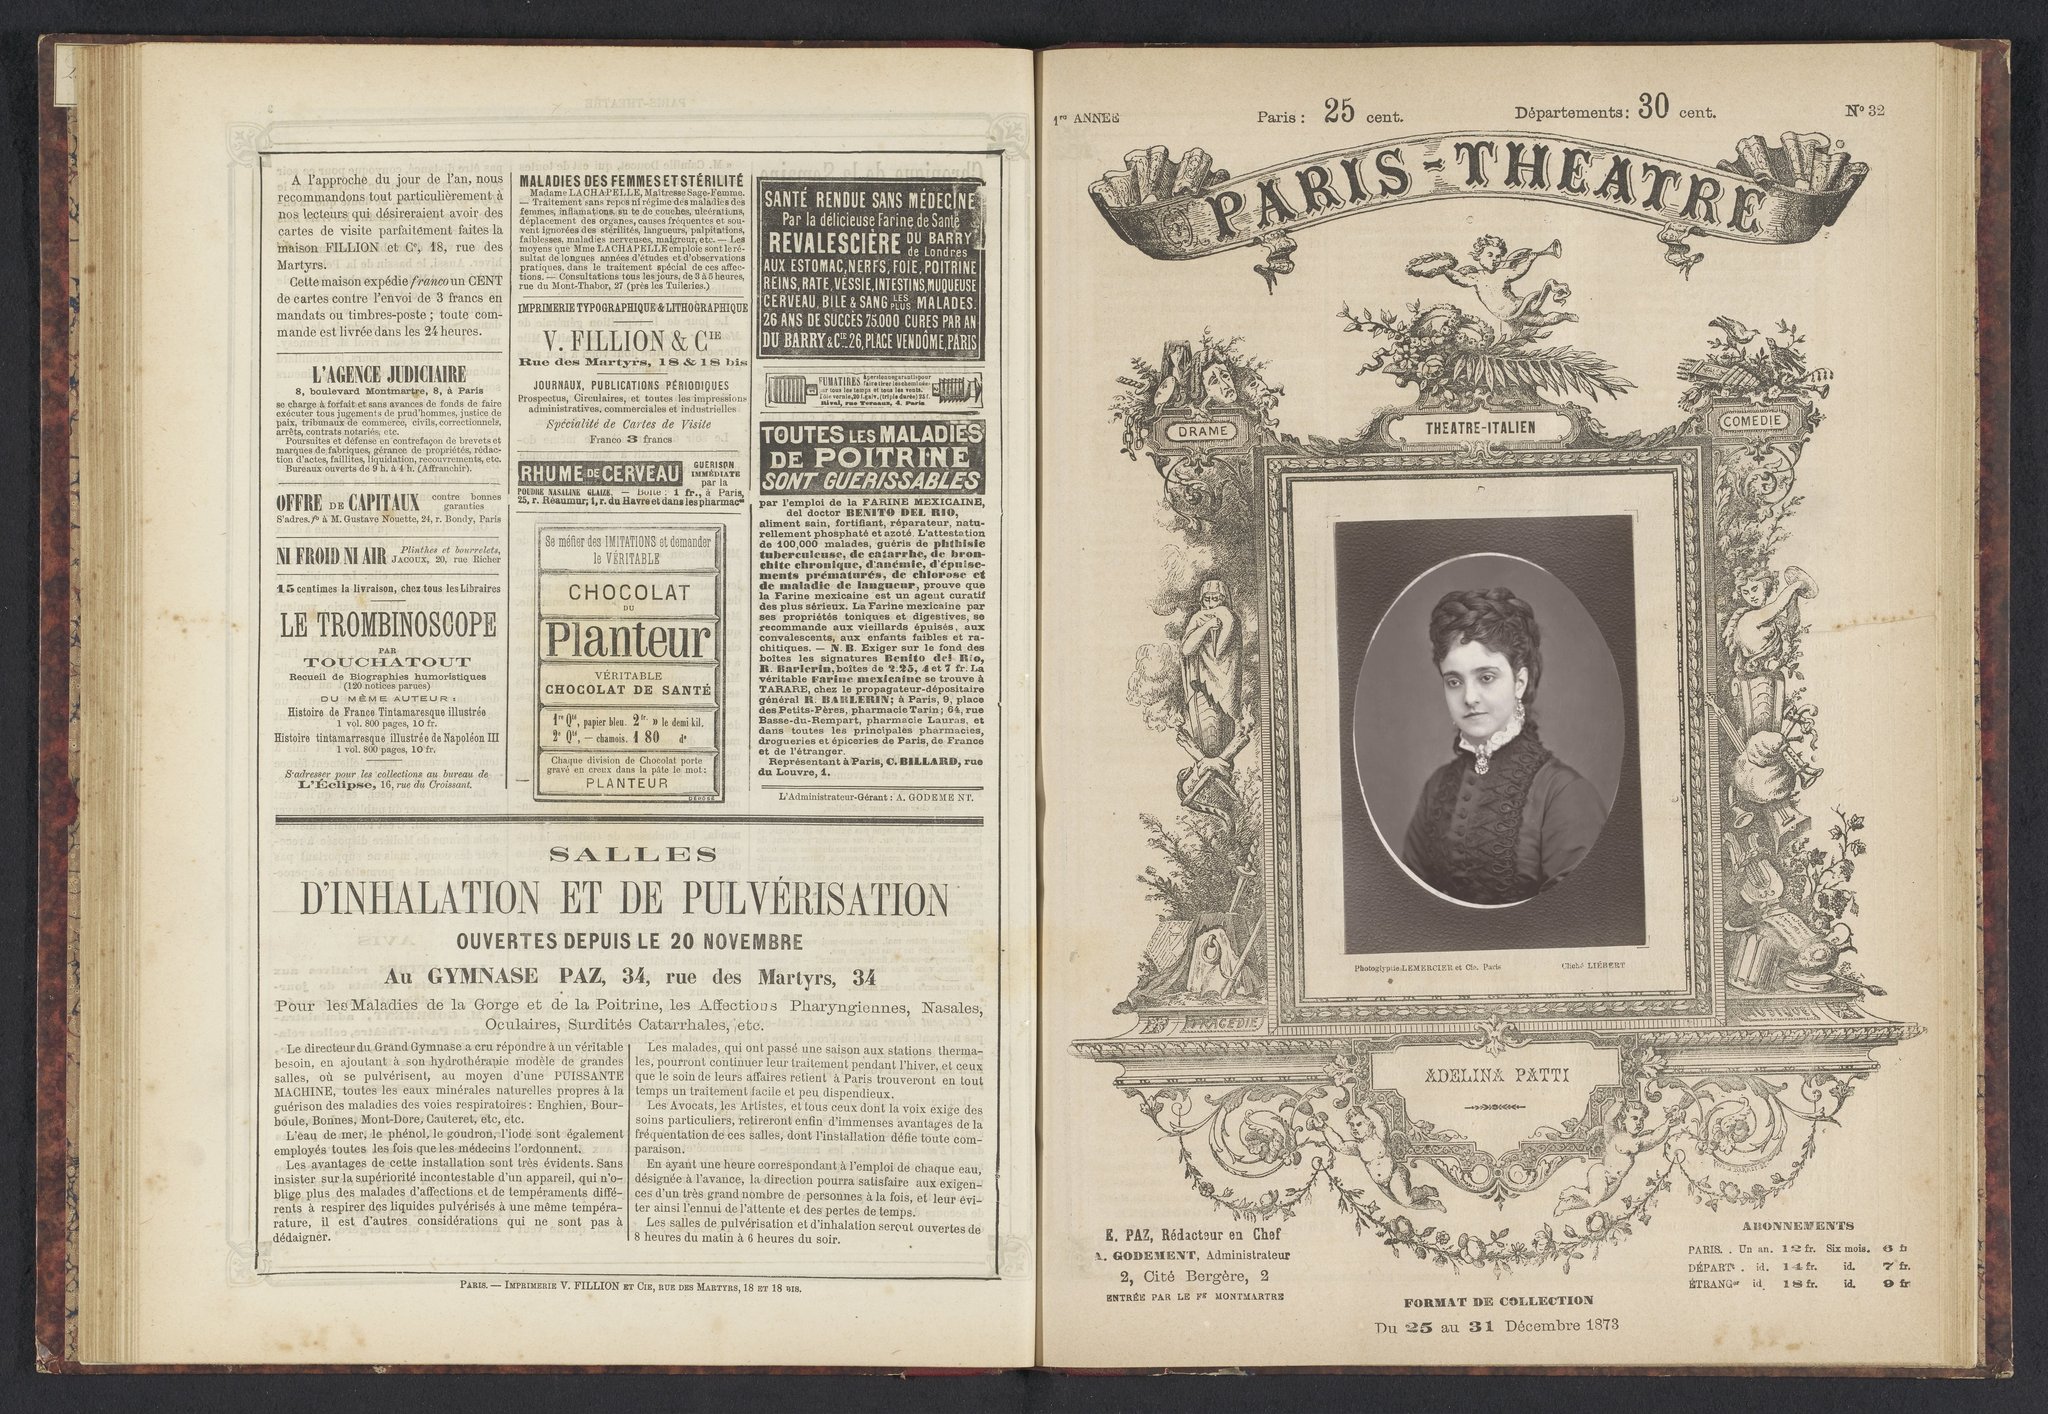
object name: photomechanical print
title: Adelina Patti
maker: alphonse-justin liébert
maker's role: fotograaf, marinier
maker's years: 1827-1914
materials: paper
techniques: woodburytype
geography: france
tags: portrait of opera-singer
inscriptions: inscription: ‘Du 25 au 31 Décembre 1873.’, number: ‘No 32’